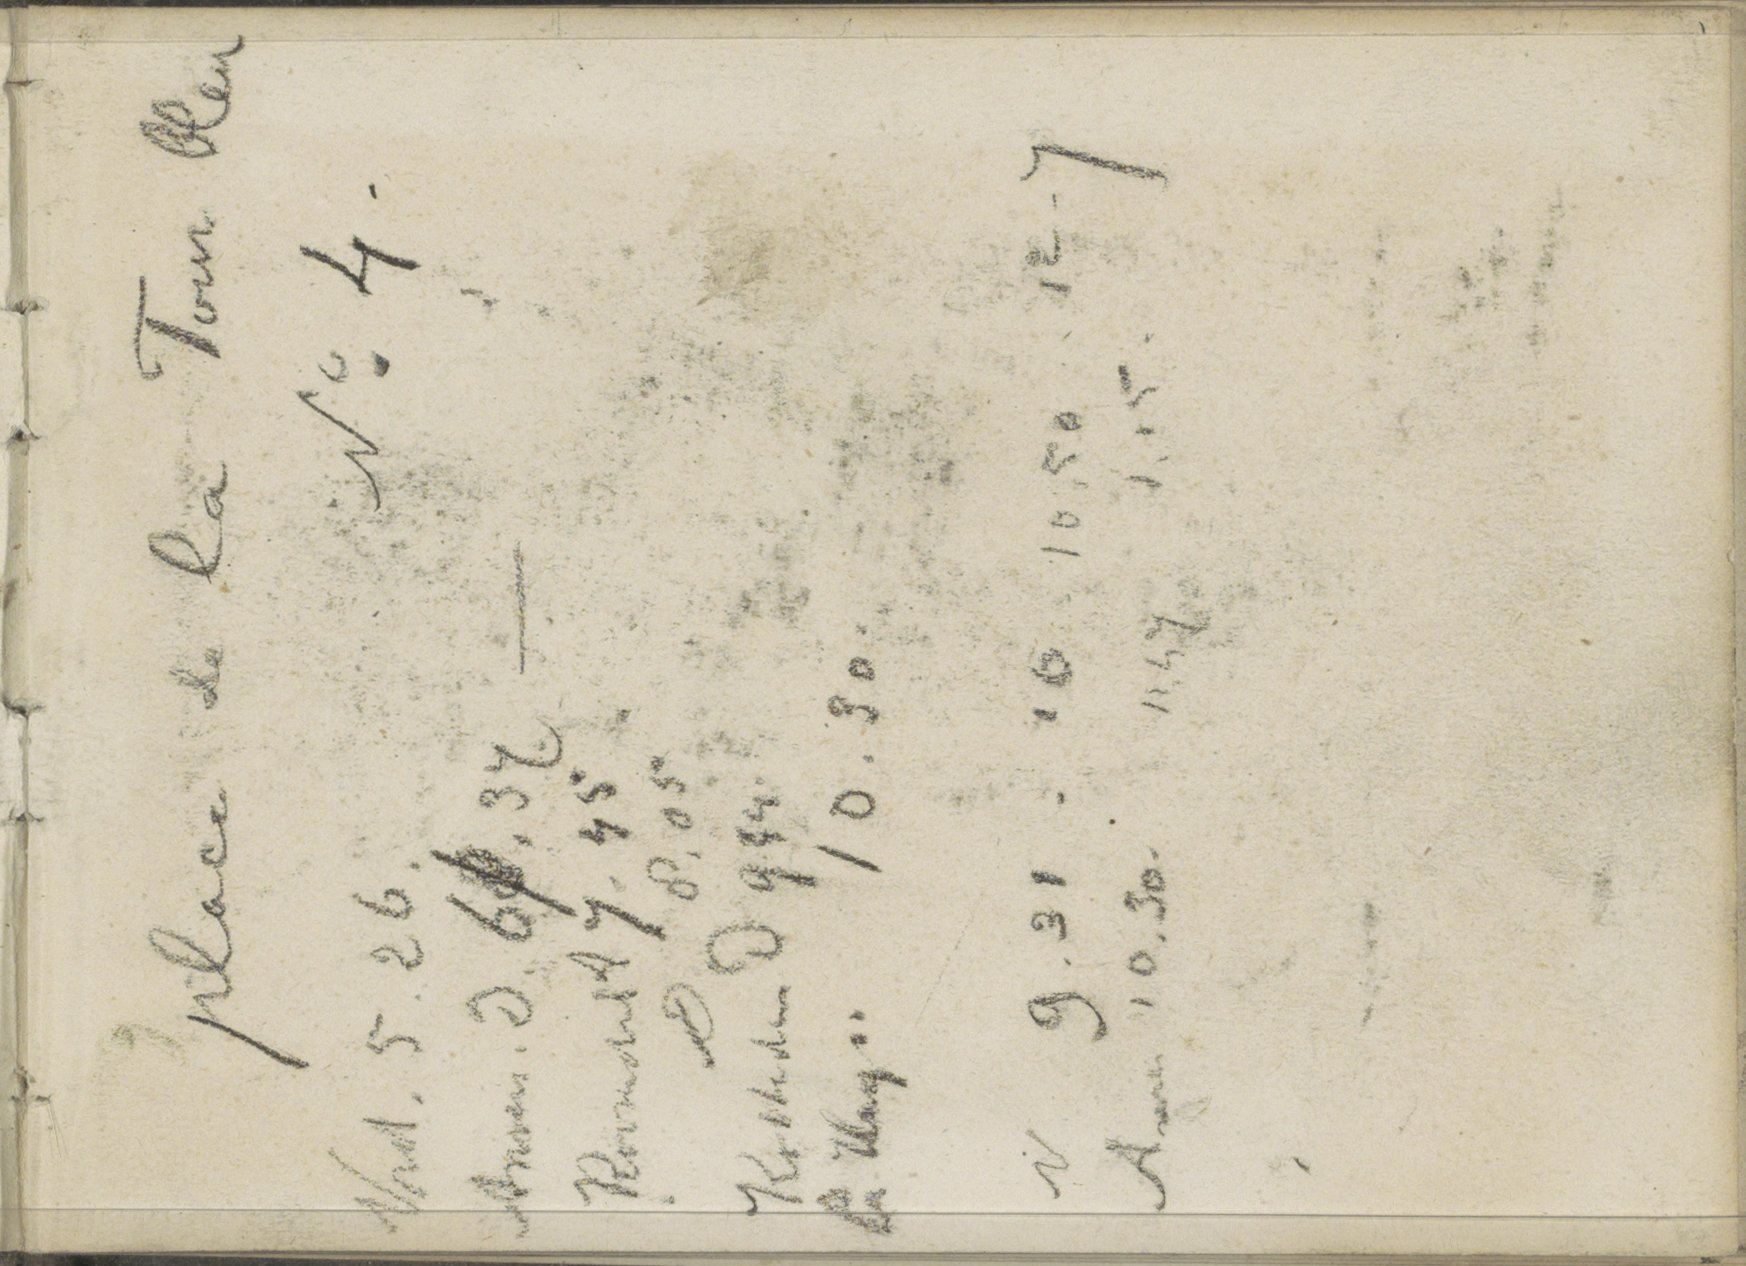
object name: sketchbook leaf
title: Blad met notities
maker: marius bauer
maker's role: draughtsman, print maker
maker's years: 1867-1932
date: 1877-1932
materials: chalk, paper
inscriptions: annotation: ‘place de la Tour bleu/ No. 4/ [...]’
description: Pagina 1 uit een schetsboek met 32 bladen.